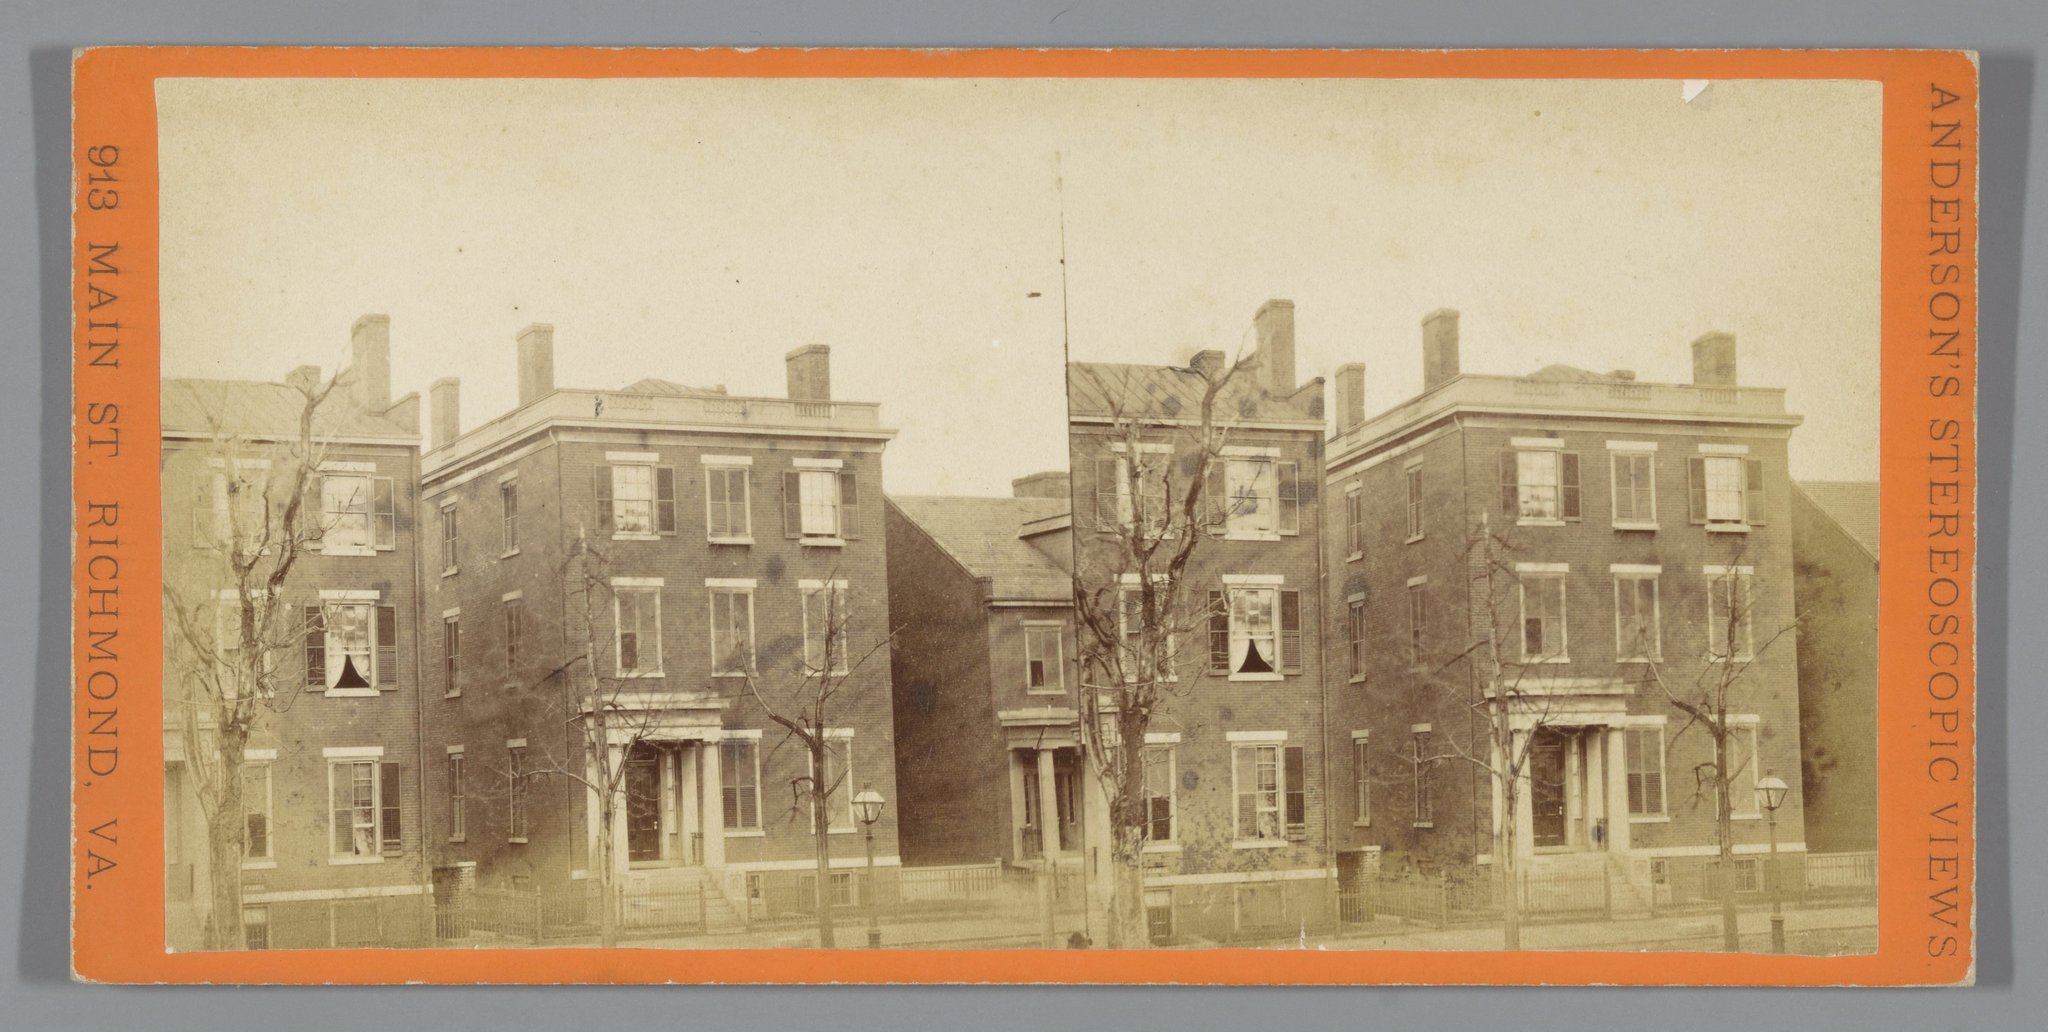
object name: stereograph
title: Views of Richmond and Vicinity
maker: david h. anderson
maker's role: fotograaf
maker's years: 1827-1905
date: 1875-1879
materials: cardboard, paper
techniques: albumen print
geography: richmond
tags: villa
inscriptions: address: ‘913 Main St. Richmond, Va.’, : ‘Views of Richmond (...) and Colonial Relics.’